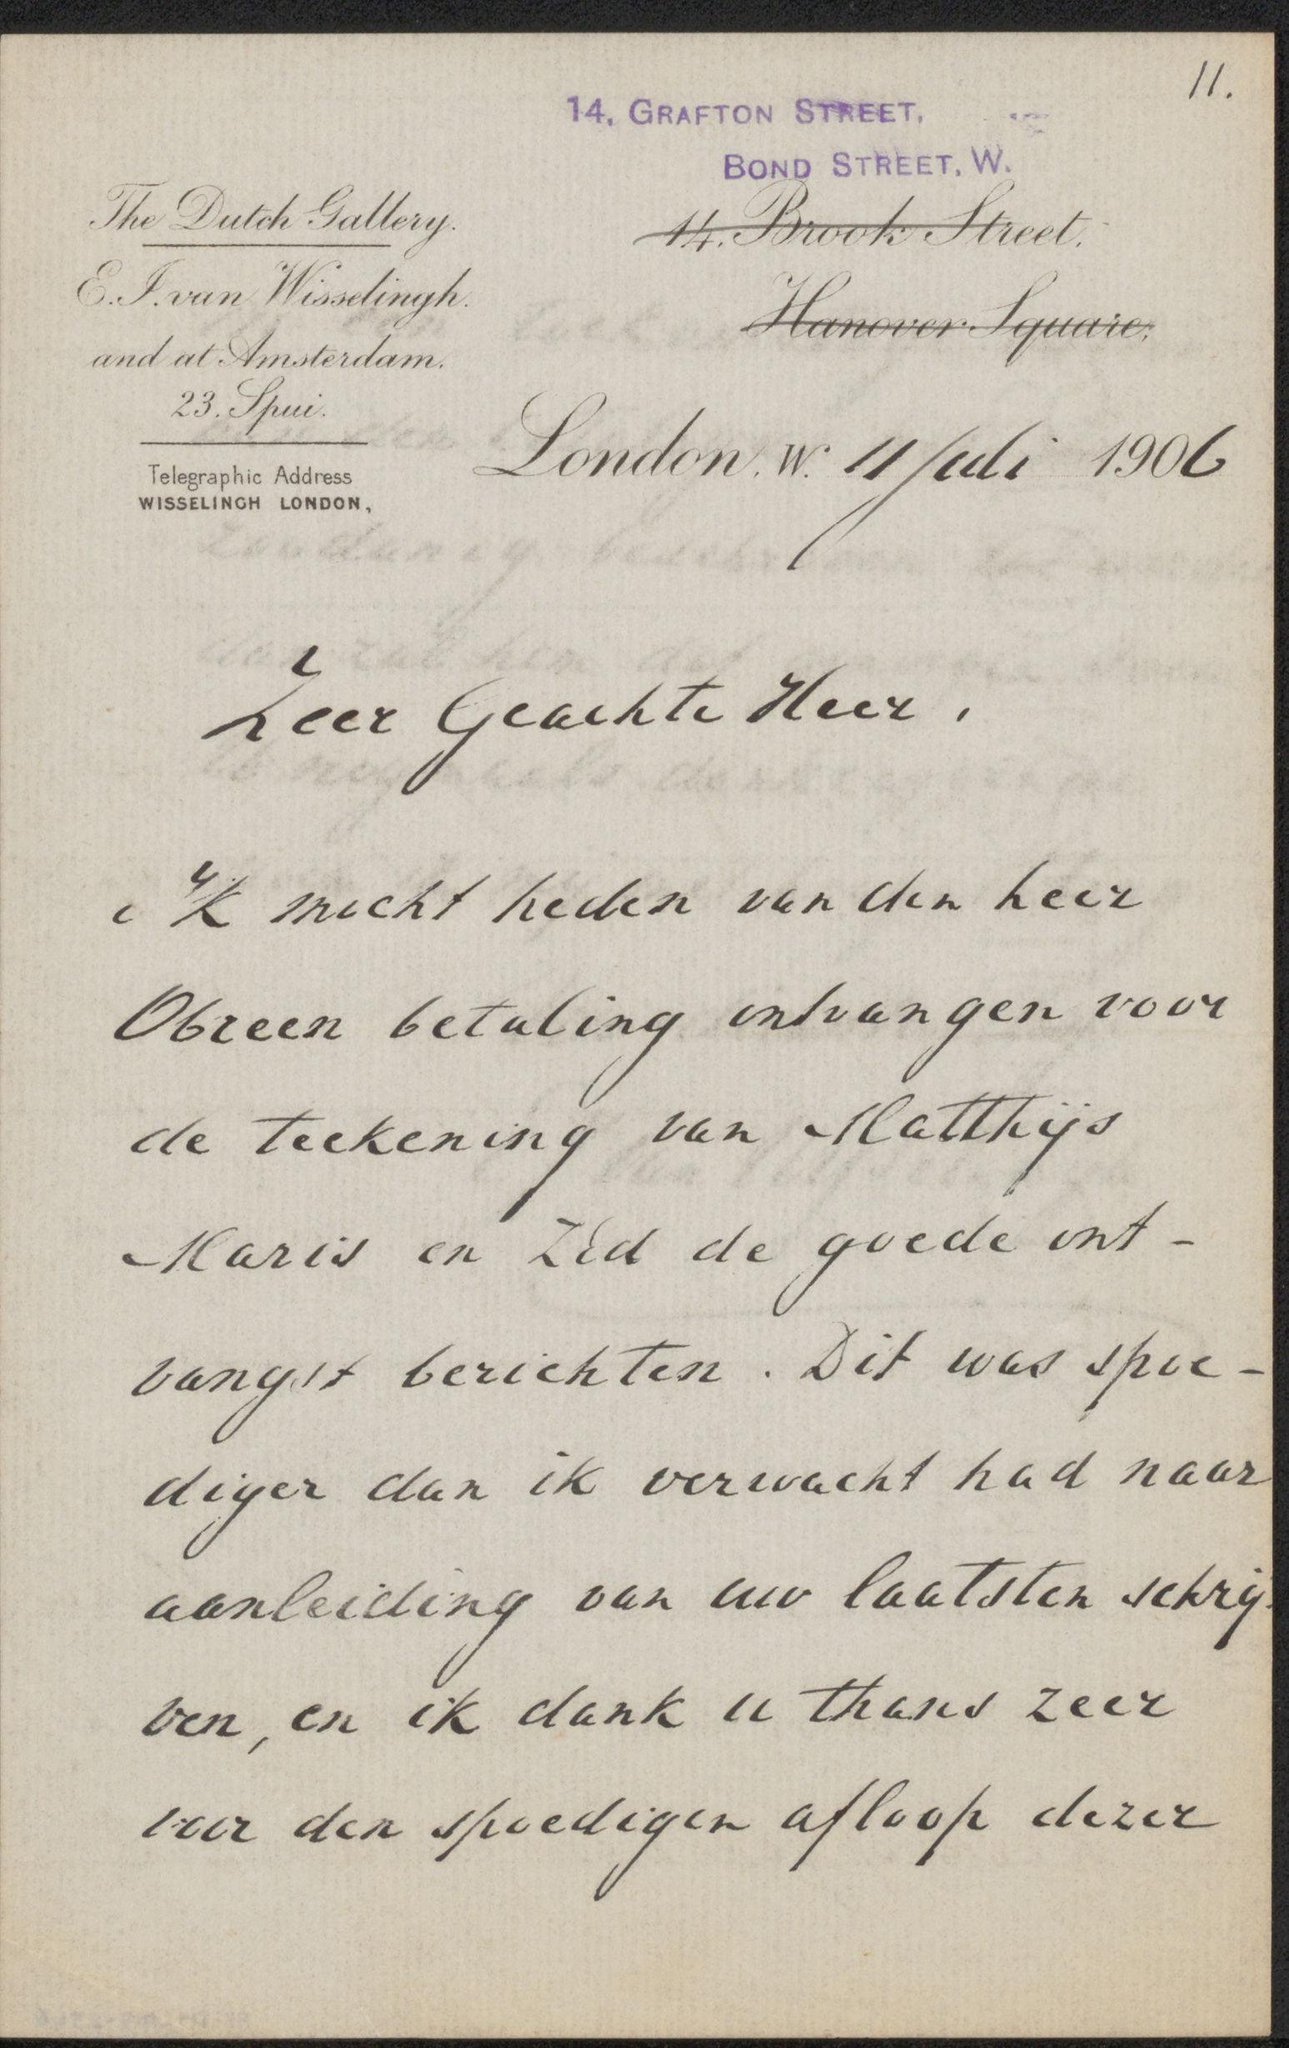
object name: letter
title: Brief aan Pieter Haverkorn van Rijsewijk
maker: elbert jan van wisselingh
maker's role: kunsthandelaar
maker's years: 1848-1912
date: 1906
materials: ink, paper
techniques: pen, printing, writing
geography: london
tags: the hague, london, painter, print maker, draughtsman, matthijs maris, amsterdam, frederik daniel otto obreen, pieter haverkorn van rijsewijk, art trade, art shop, drawing, art collecting, money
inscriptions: watermark, address: ‘14, GRAFTON STREET,/ BOND STREET, W.’